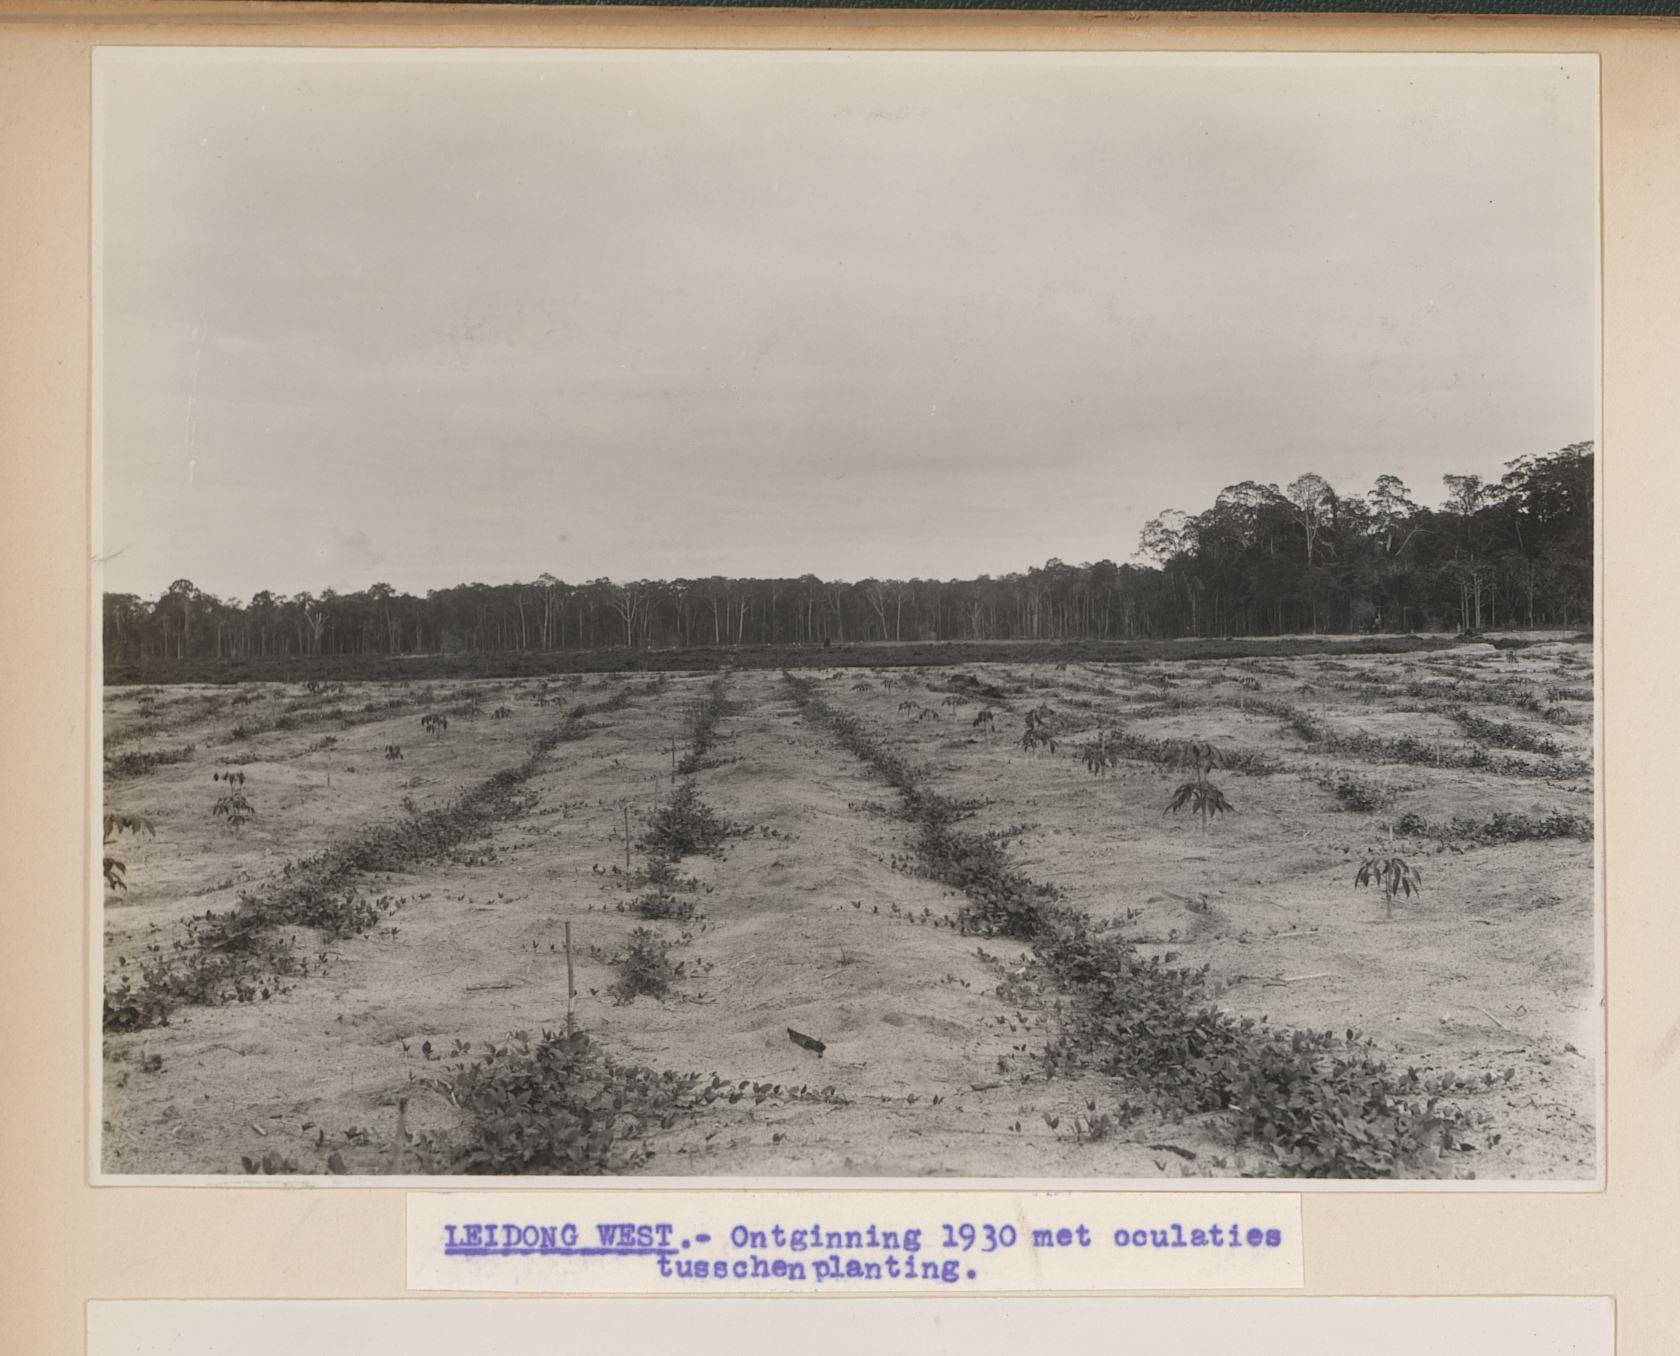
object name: photograph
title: Leidong West - Ontginning 1930 met oculaties tusschenplanting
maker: Anonymous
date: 1930-1939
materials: photographic support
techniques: gelatin silver print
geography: sumatra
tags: plantation, (non-fruit) products of plants or trees: rubber, sumatra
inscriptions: inscription: ‘Leidong West - Ontginning 1930 met oculaties tusschenplanting’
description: Ontginning van nieuwe velden op Leidong West met nieuwe aanplant van rubberbomen en bodembedekkers. Onderdeel van het fotoalbum over de plantages Leidong West en Kanopan Oeloe van de Cultuur Maatschappij Leidong West op Sumatra in de jaren 1925-1939.